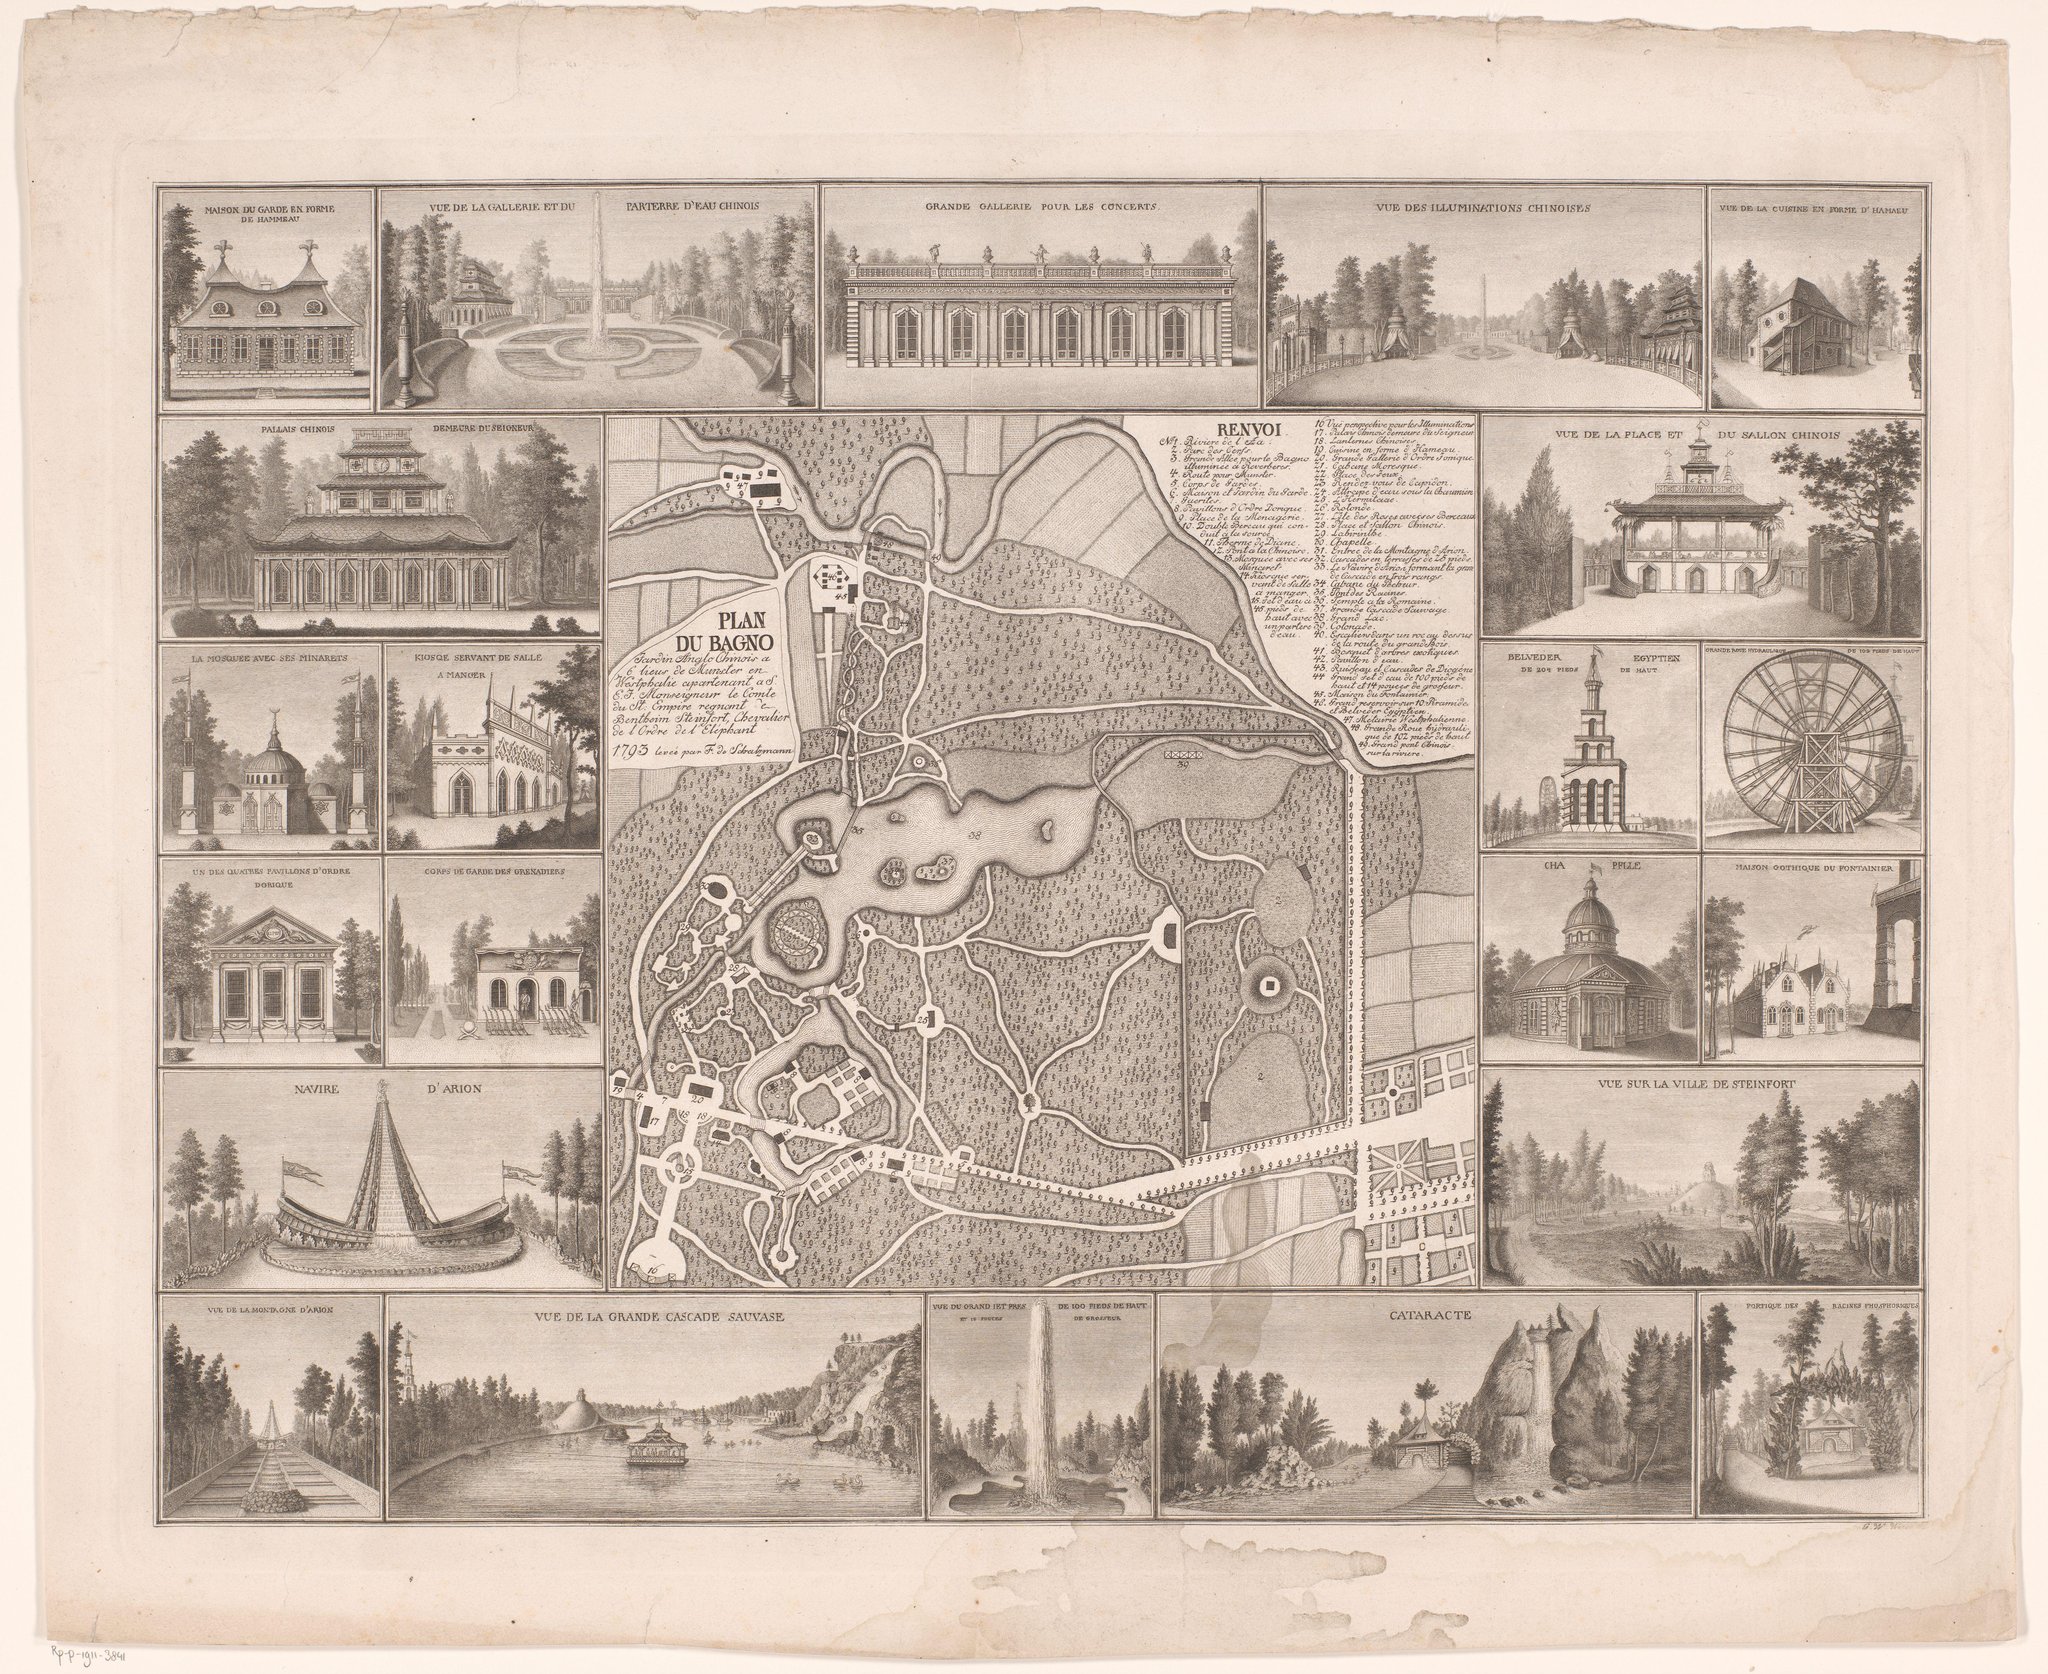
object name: print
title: Plan du Bagno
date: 1793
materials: paper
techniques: etching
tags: plan, map of garden, water-works in garden, garden buildings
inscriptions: collector's mark: Lugt 2228